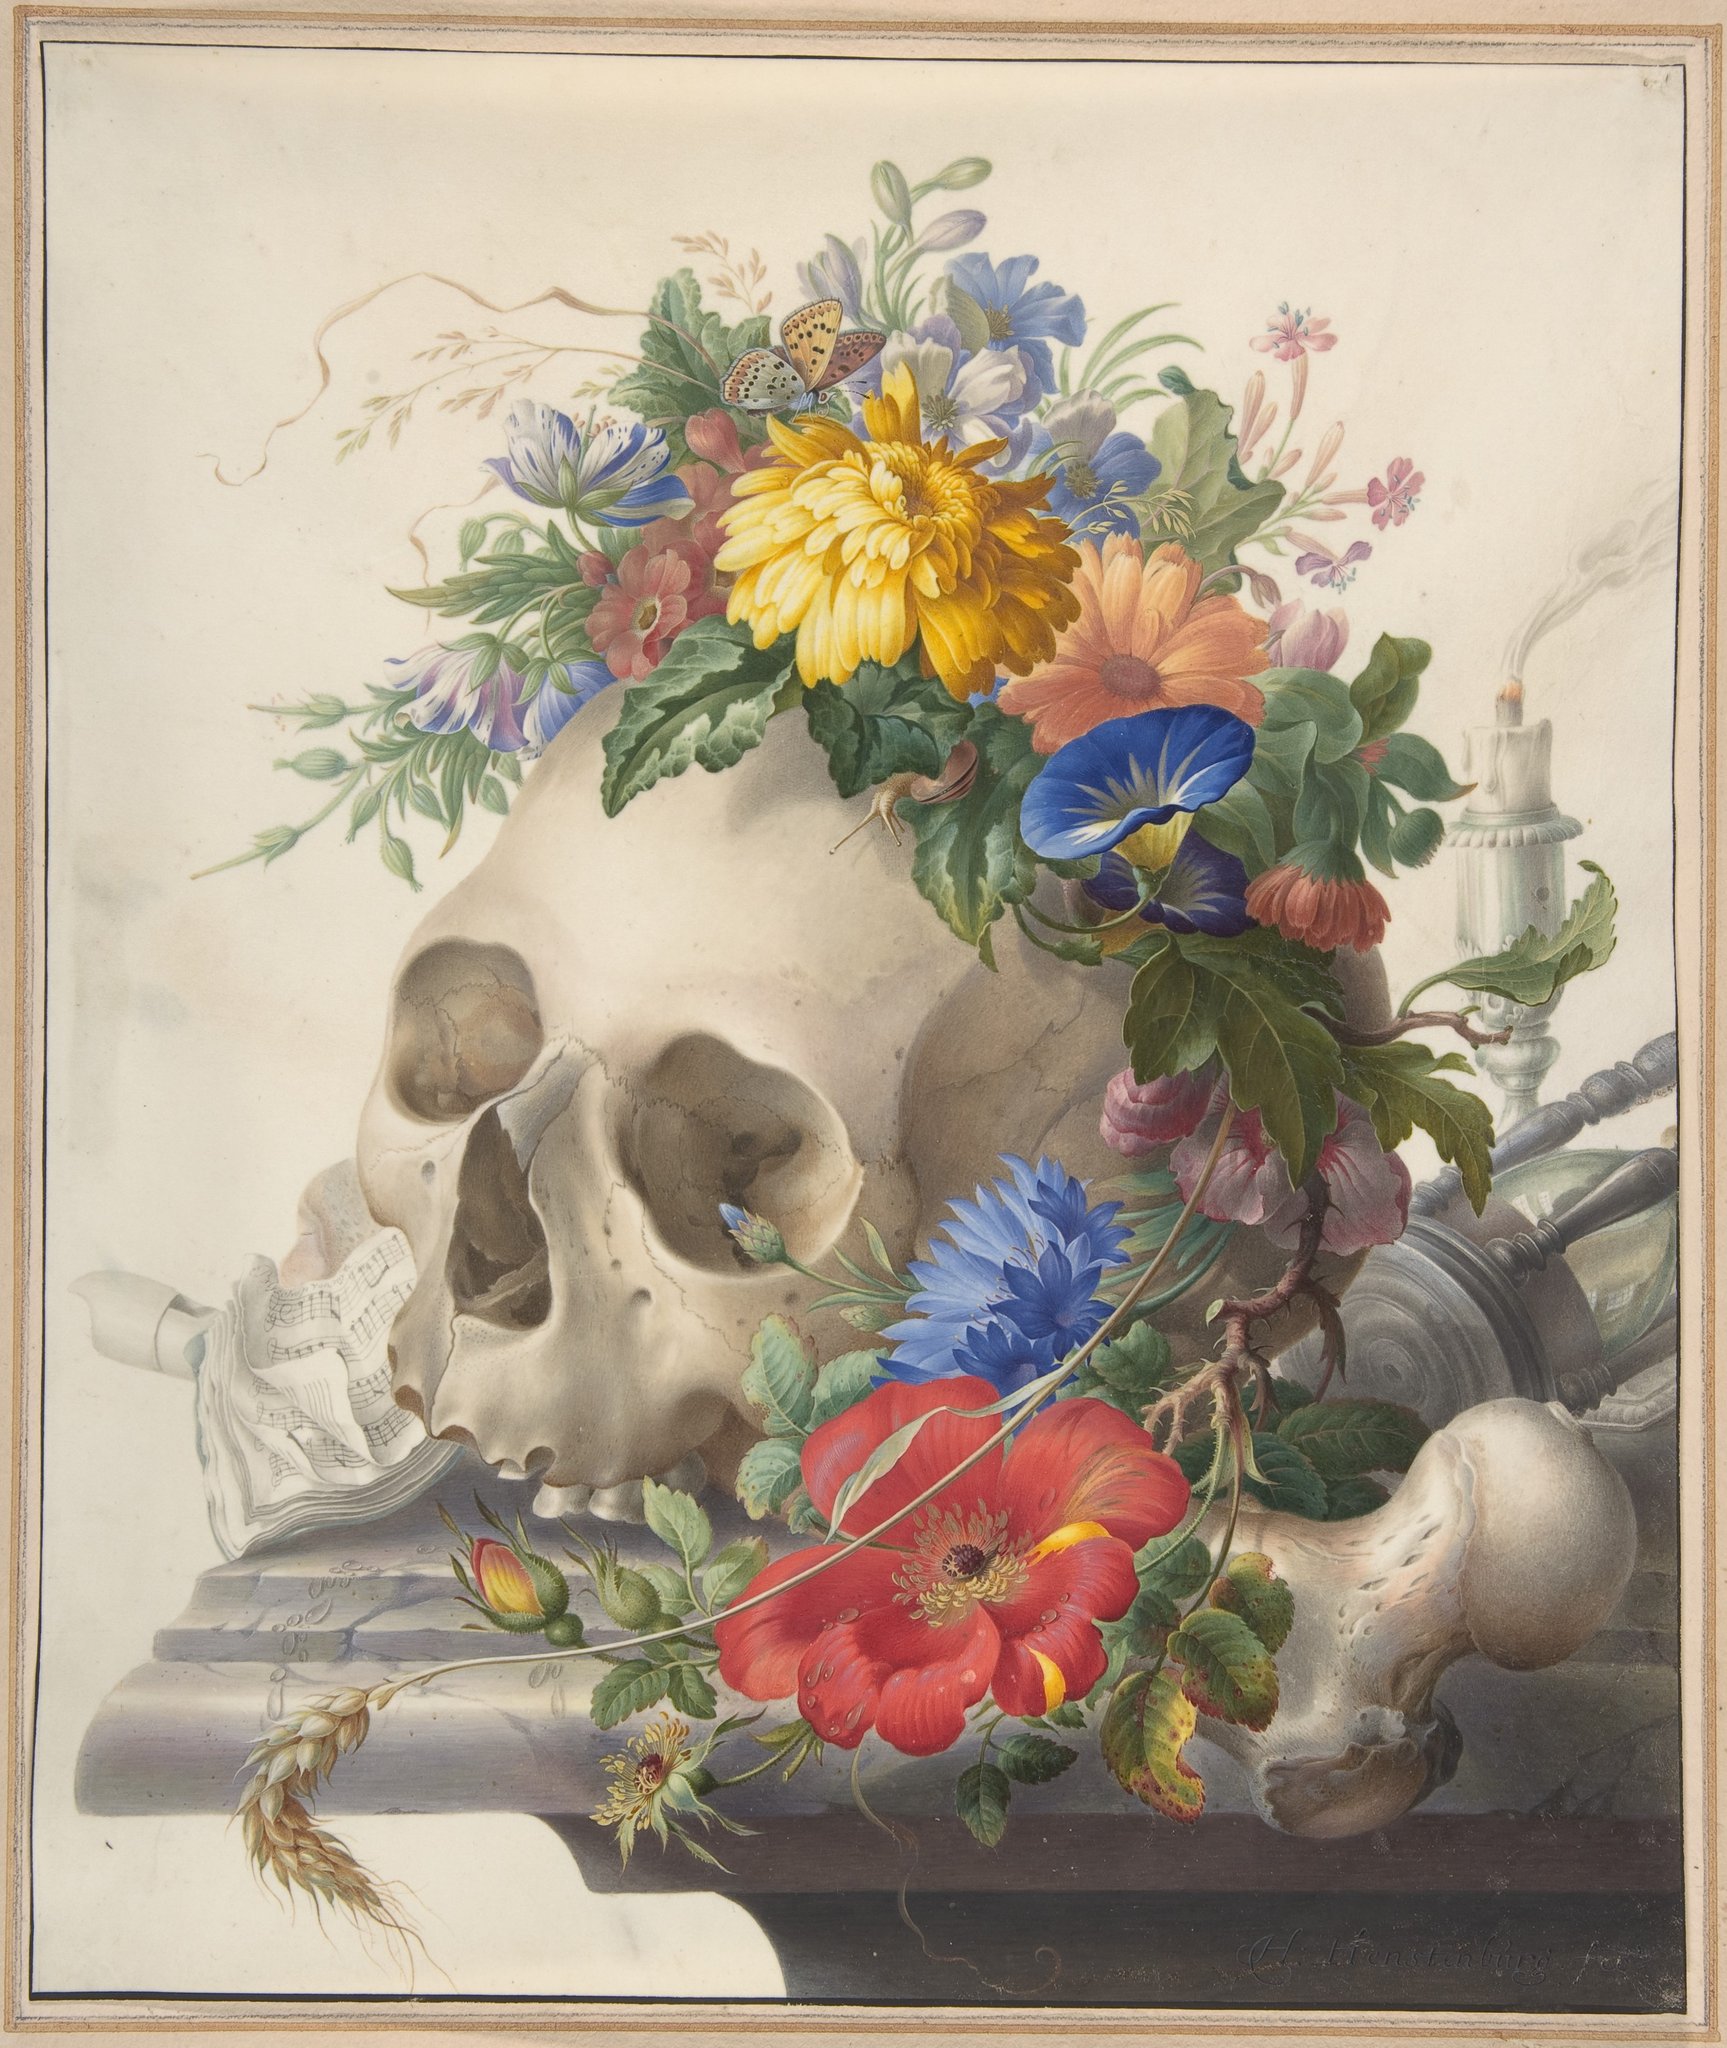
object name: drawing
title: Vanitas Still Life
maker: herman henstenburgh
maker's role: artist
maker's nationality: dutch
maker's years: 1667-1726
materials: gouache, gum arabic, parchment, watercolor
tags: skulls,flowers,still life,hourglass